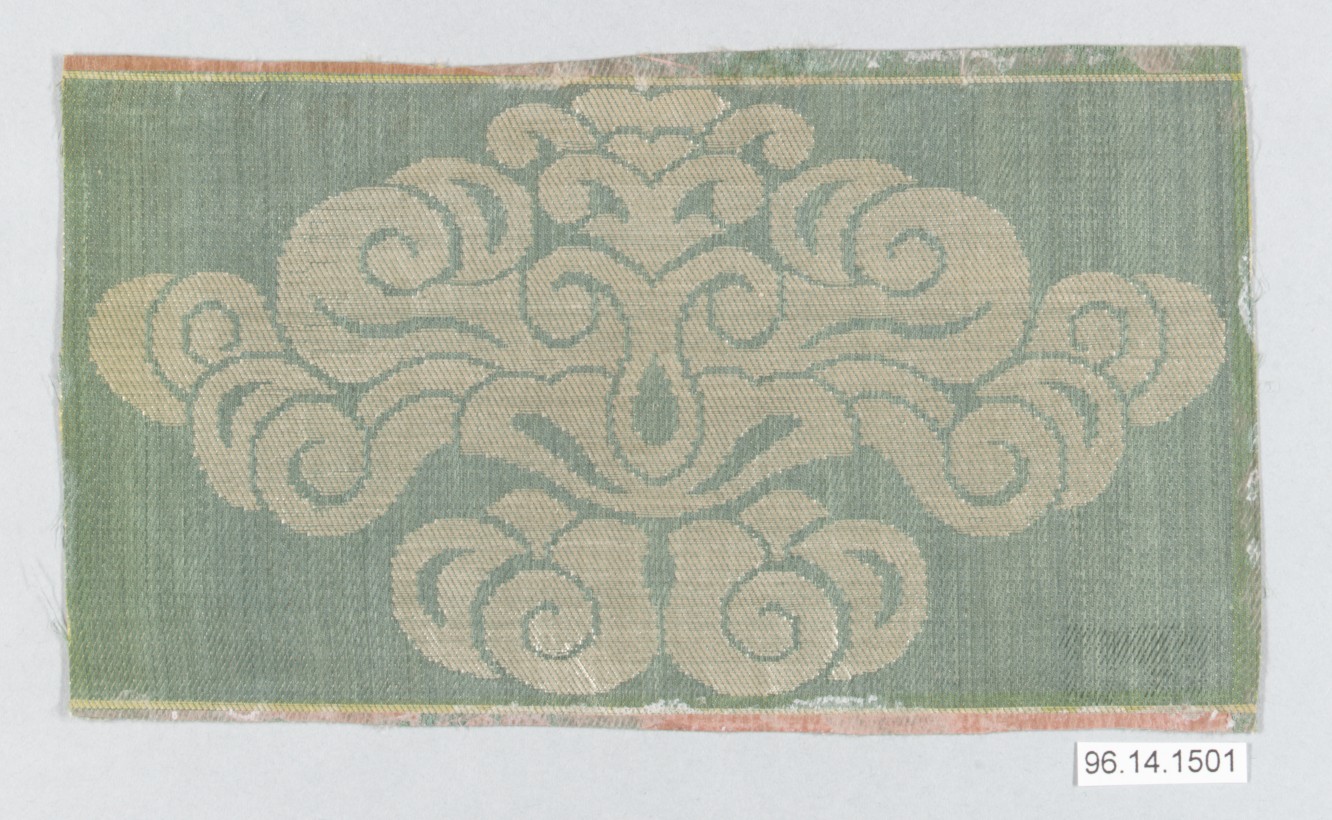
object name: piece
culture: japanese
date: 1601-1700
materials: silk